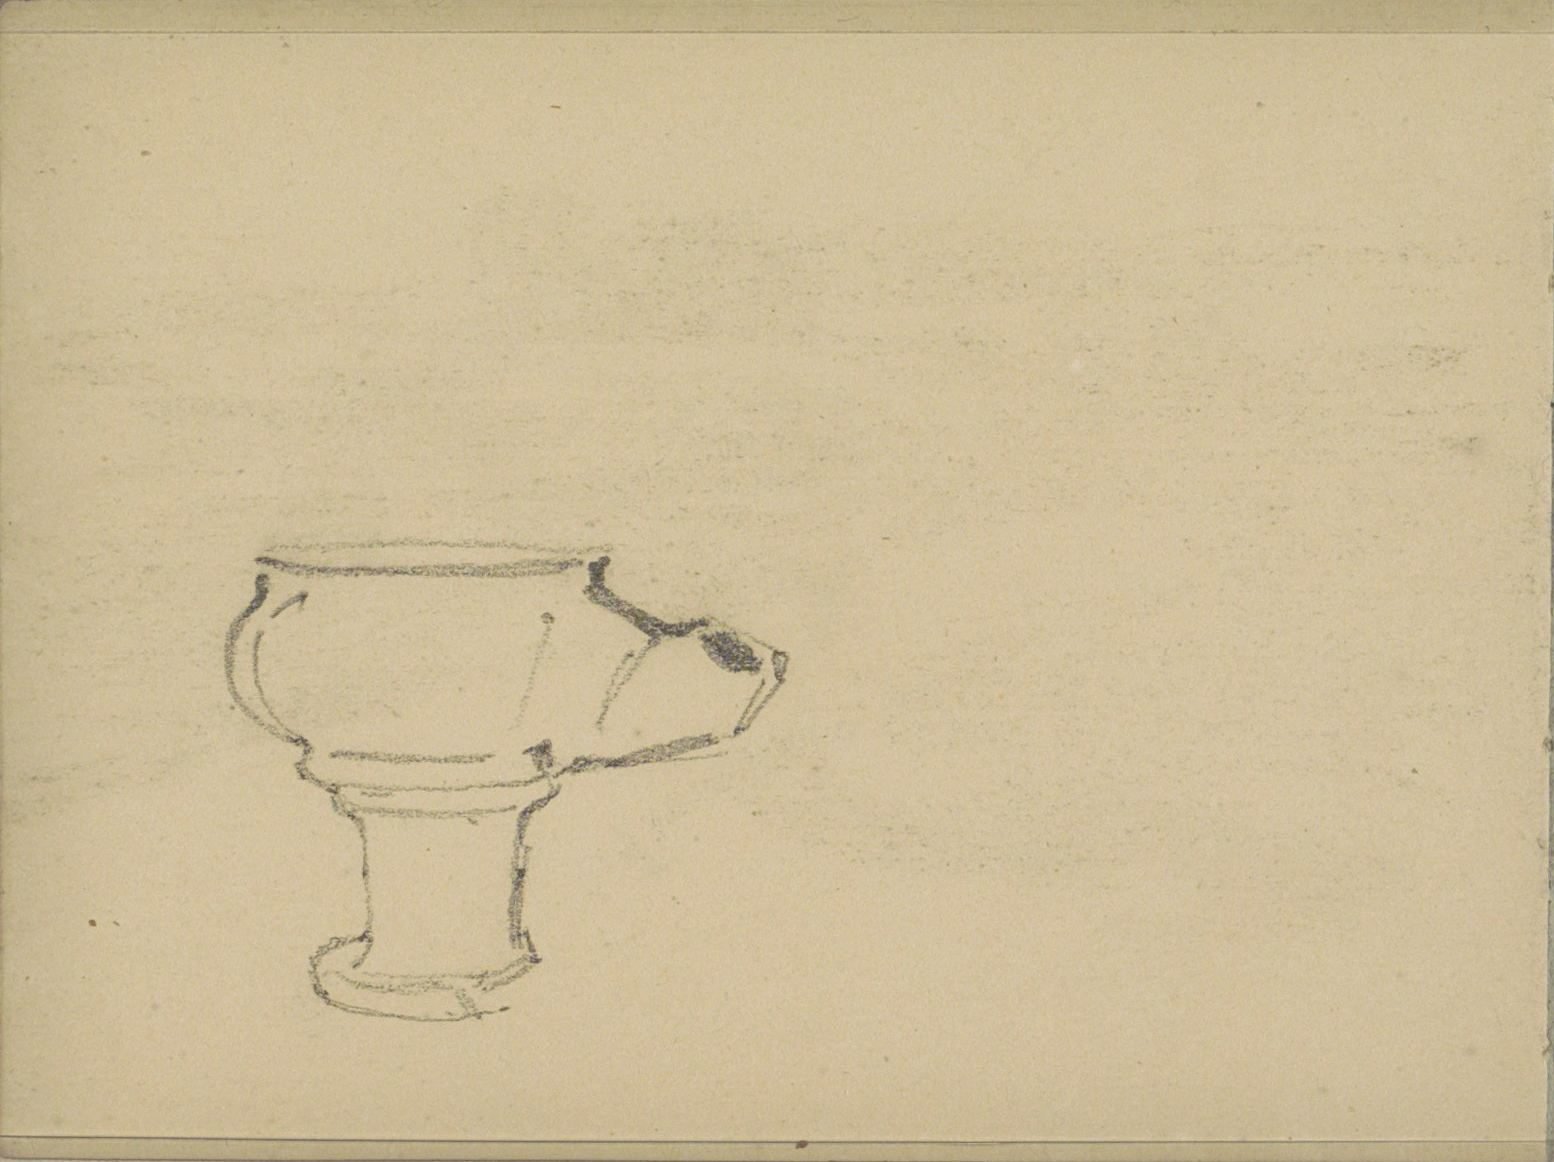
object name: sketchbook leaf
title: Kan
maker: george clausen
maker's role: draughtsman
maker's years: 1852-1912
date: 1874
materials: paper, pencil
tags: container of ceramics: jar, jug, pot, vase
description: Blad 16 verso uit een schetsboek met 37 bladen.